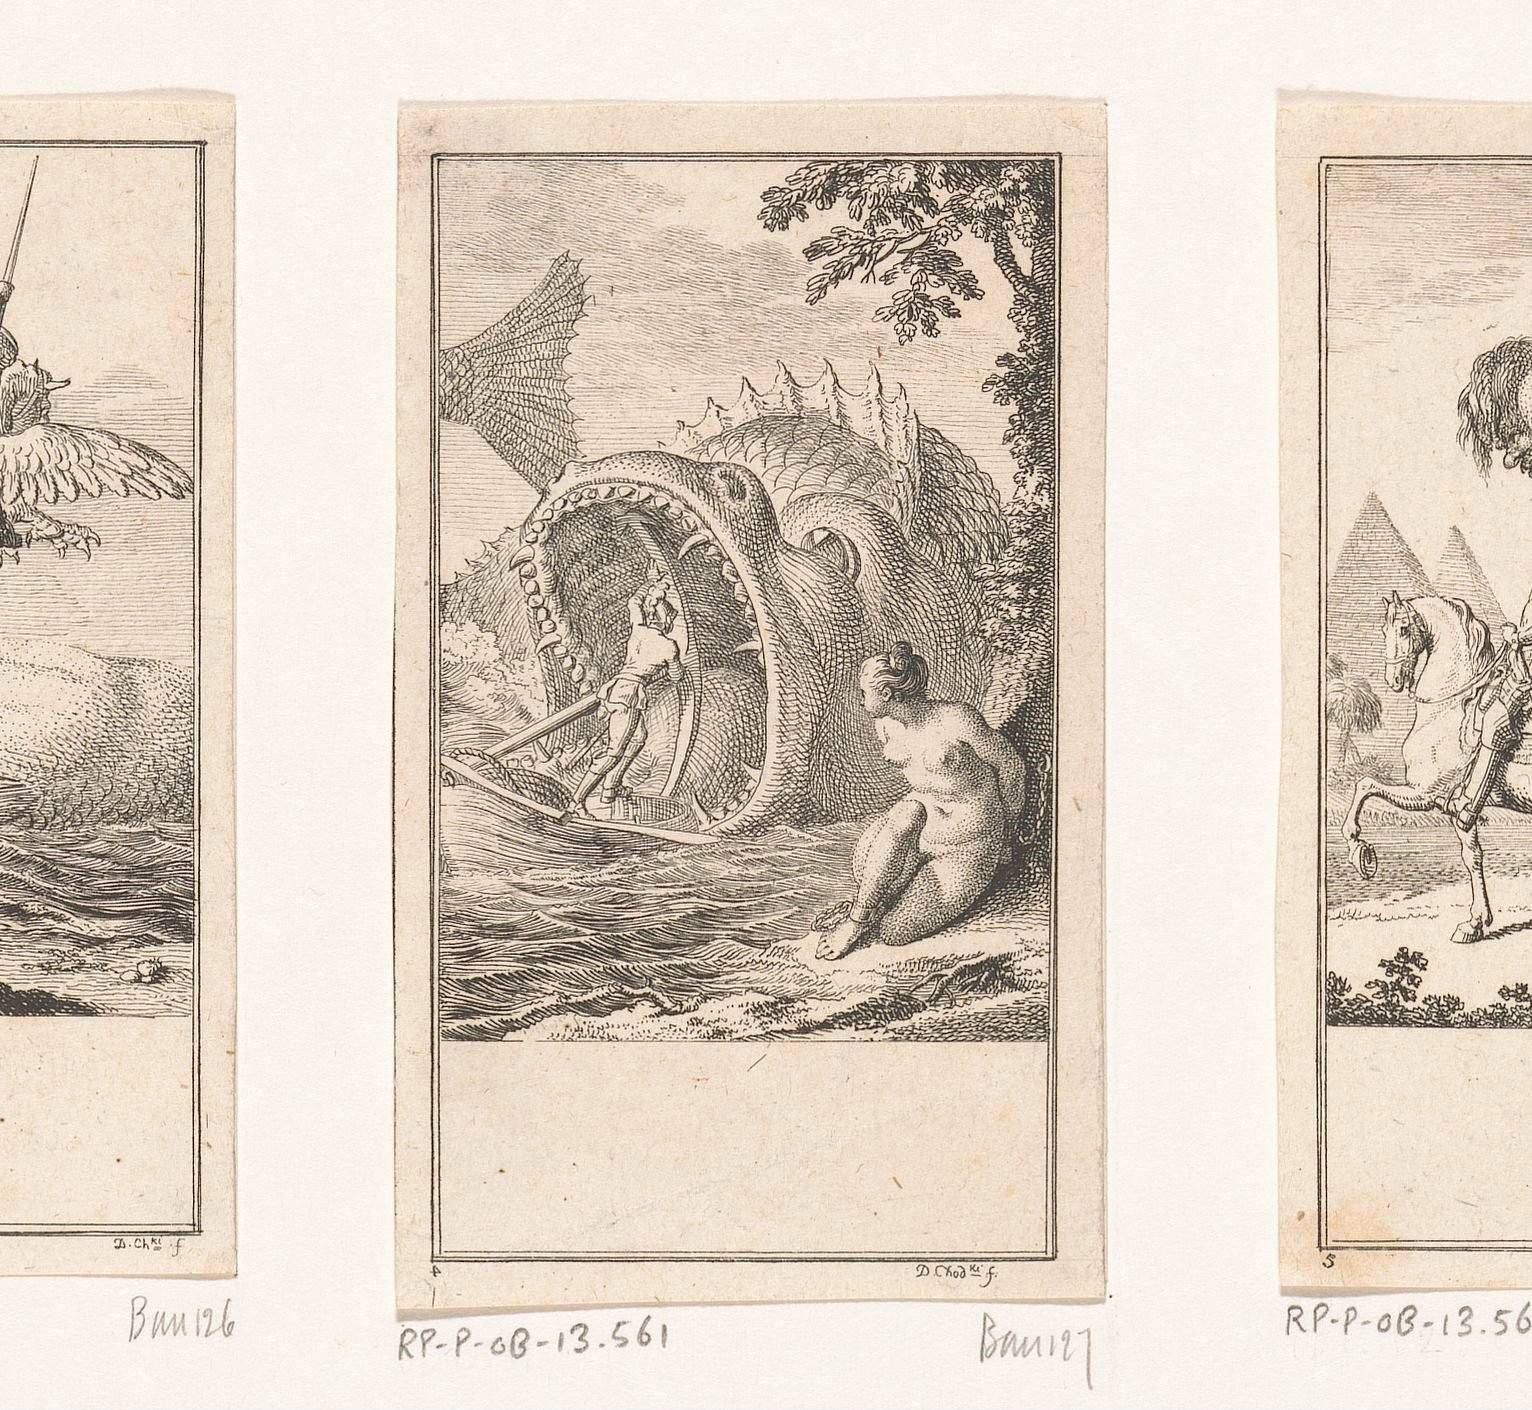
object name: print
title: Orlando in gevecht met de Orka van Ebuda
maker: daniel nikolaus chodowiecki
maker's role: draughtsman, print maker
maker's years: 1726-1801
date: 1771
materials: paper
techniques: etching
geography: berlin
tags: ludovico ariosto, swimming mammals: whale - ff - fabulous animals (sometimes wrongly called 'grotesques'); 'mostri' (ripa), parts of ship's exterior: anchor, (scenes from) specific works of literature: ariosto, orlando furioso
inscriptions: collector's mark: Lugt 240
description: Vierde prent afkomstig uit een serie met twaalf scènes die 'Orlando Furioso' van Ludovico Ariosto illustreren. De twaalf scènes werden samen op een plaat geëtst. De tweede staat van deze serie is gebruikt als illustratie in: 'Almanac Généalogique pour l'an 1772'.